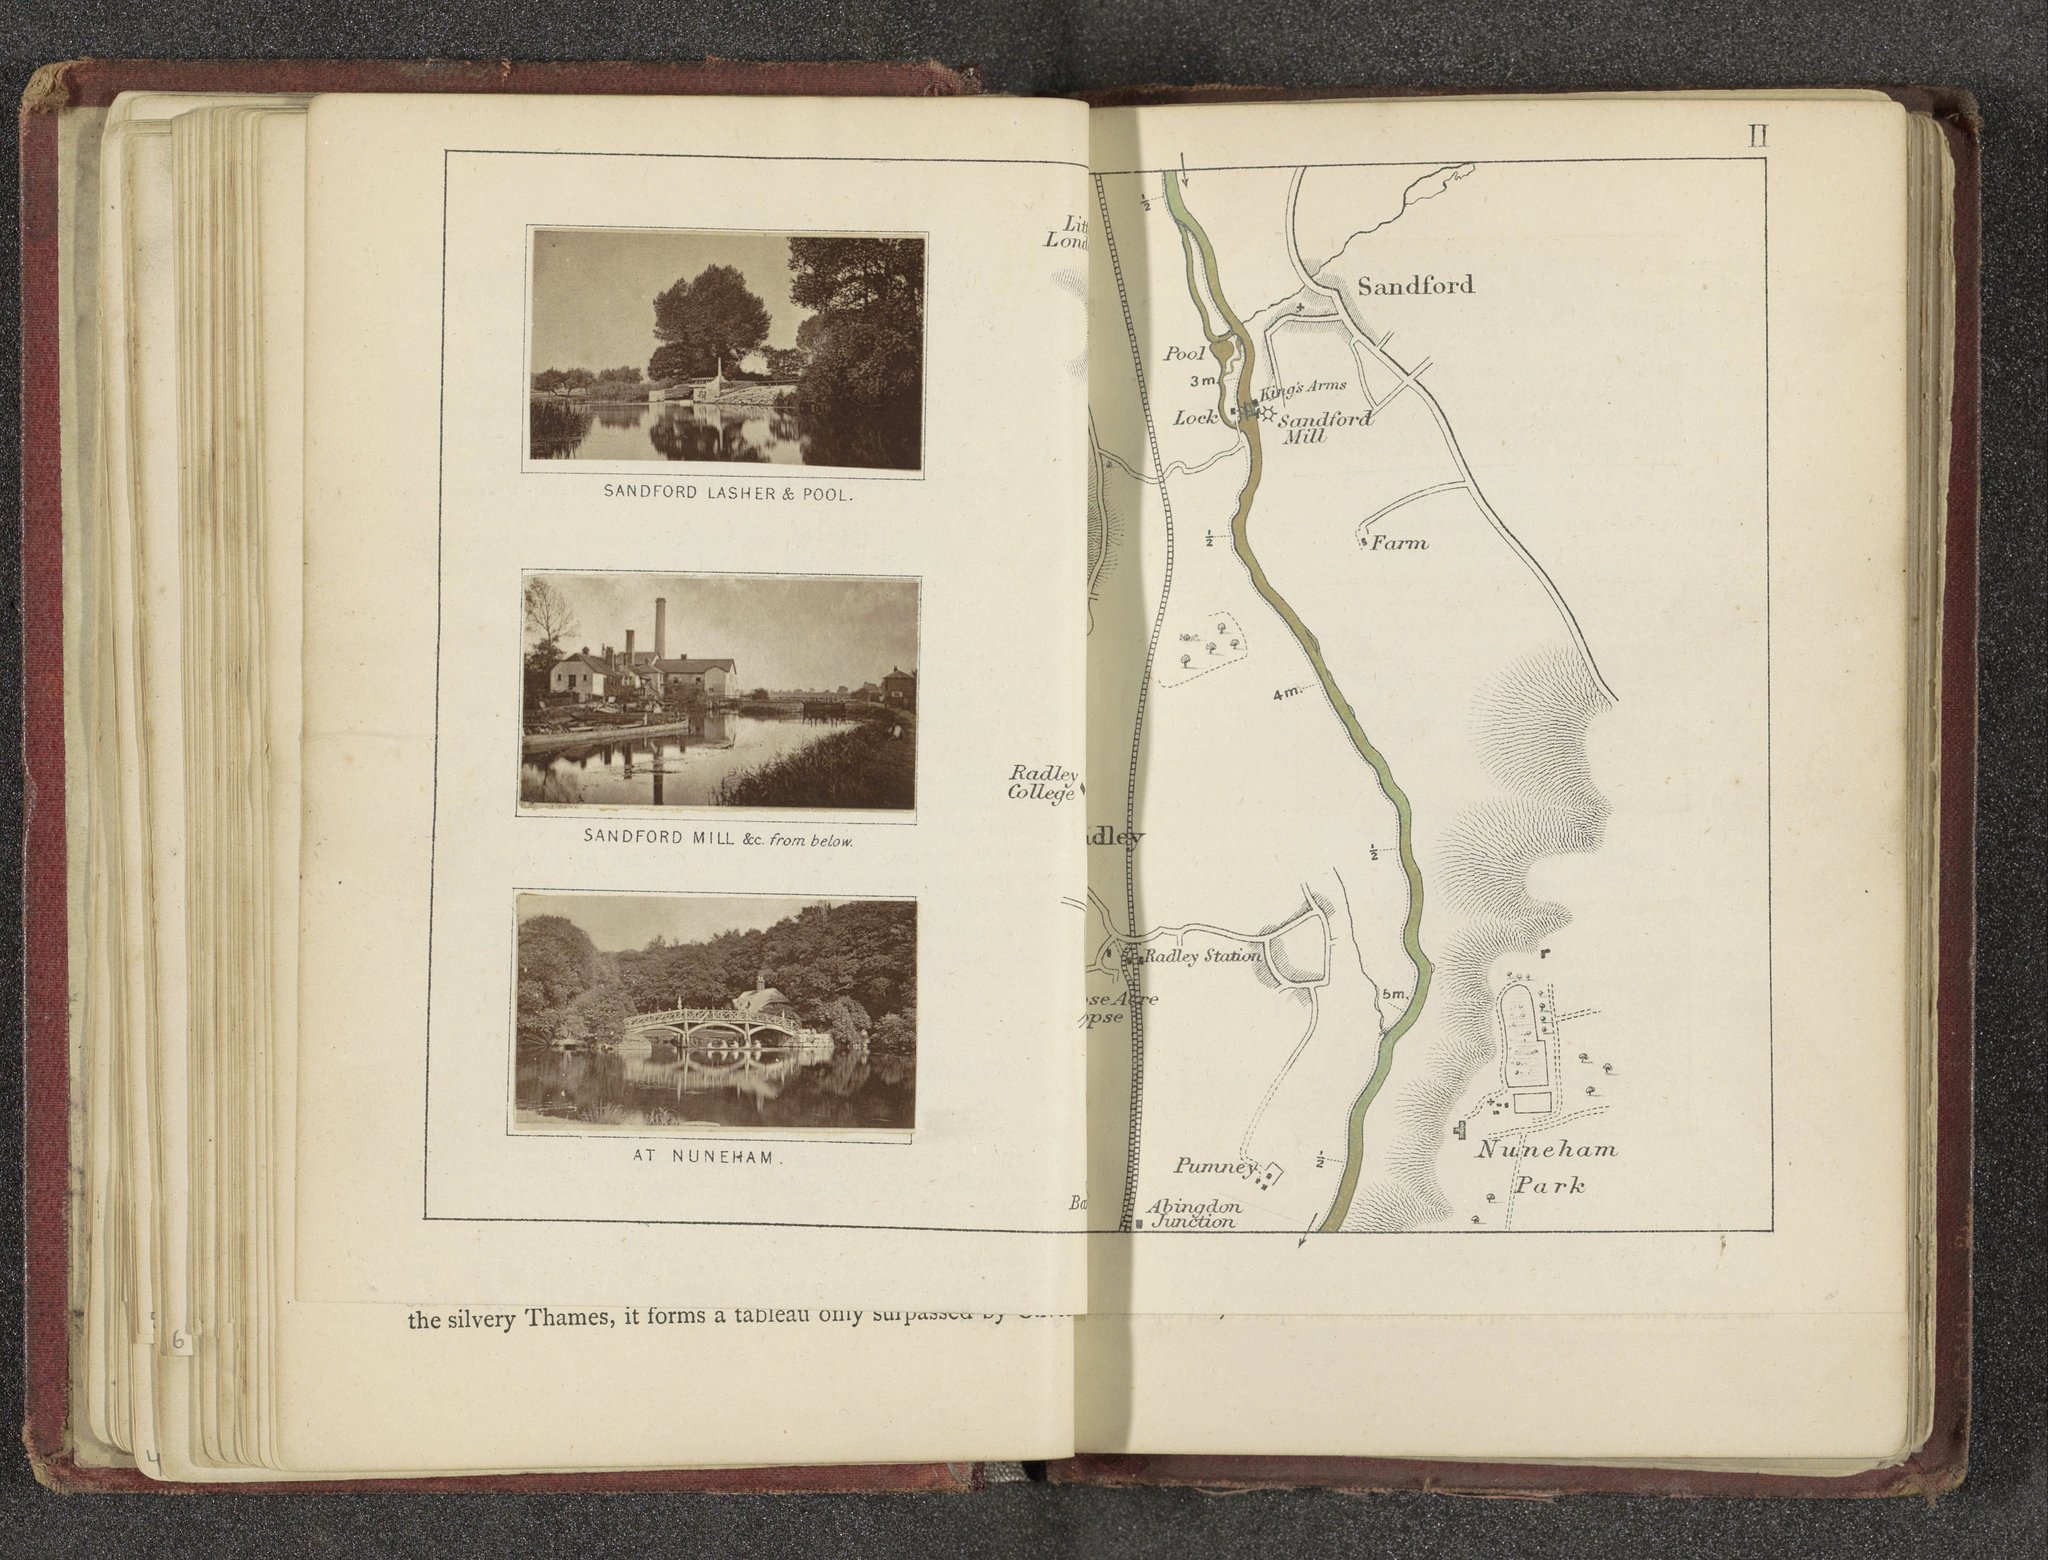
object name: photomechanical print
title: Kaart met drie afbeeldingen van plaatsen langs de Theems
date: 1878-1879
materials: paper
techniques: engraving, woodburytype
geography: oxfordshire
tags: sluice, weir, river, watermill in landscape, bridge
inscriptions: inscription: ‘Sandford lasher & pool Sandford mill &c. fom below At Nuneham.’, number: ‘11’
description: Boven en midden: waterkering en een watermolen bij Sandford-on-Thames, onder: brug bij Nuneham Courtenay.